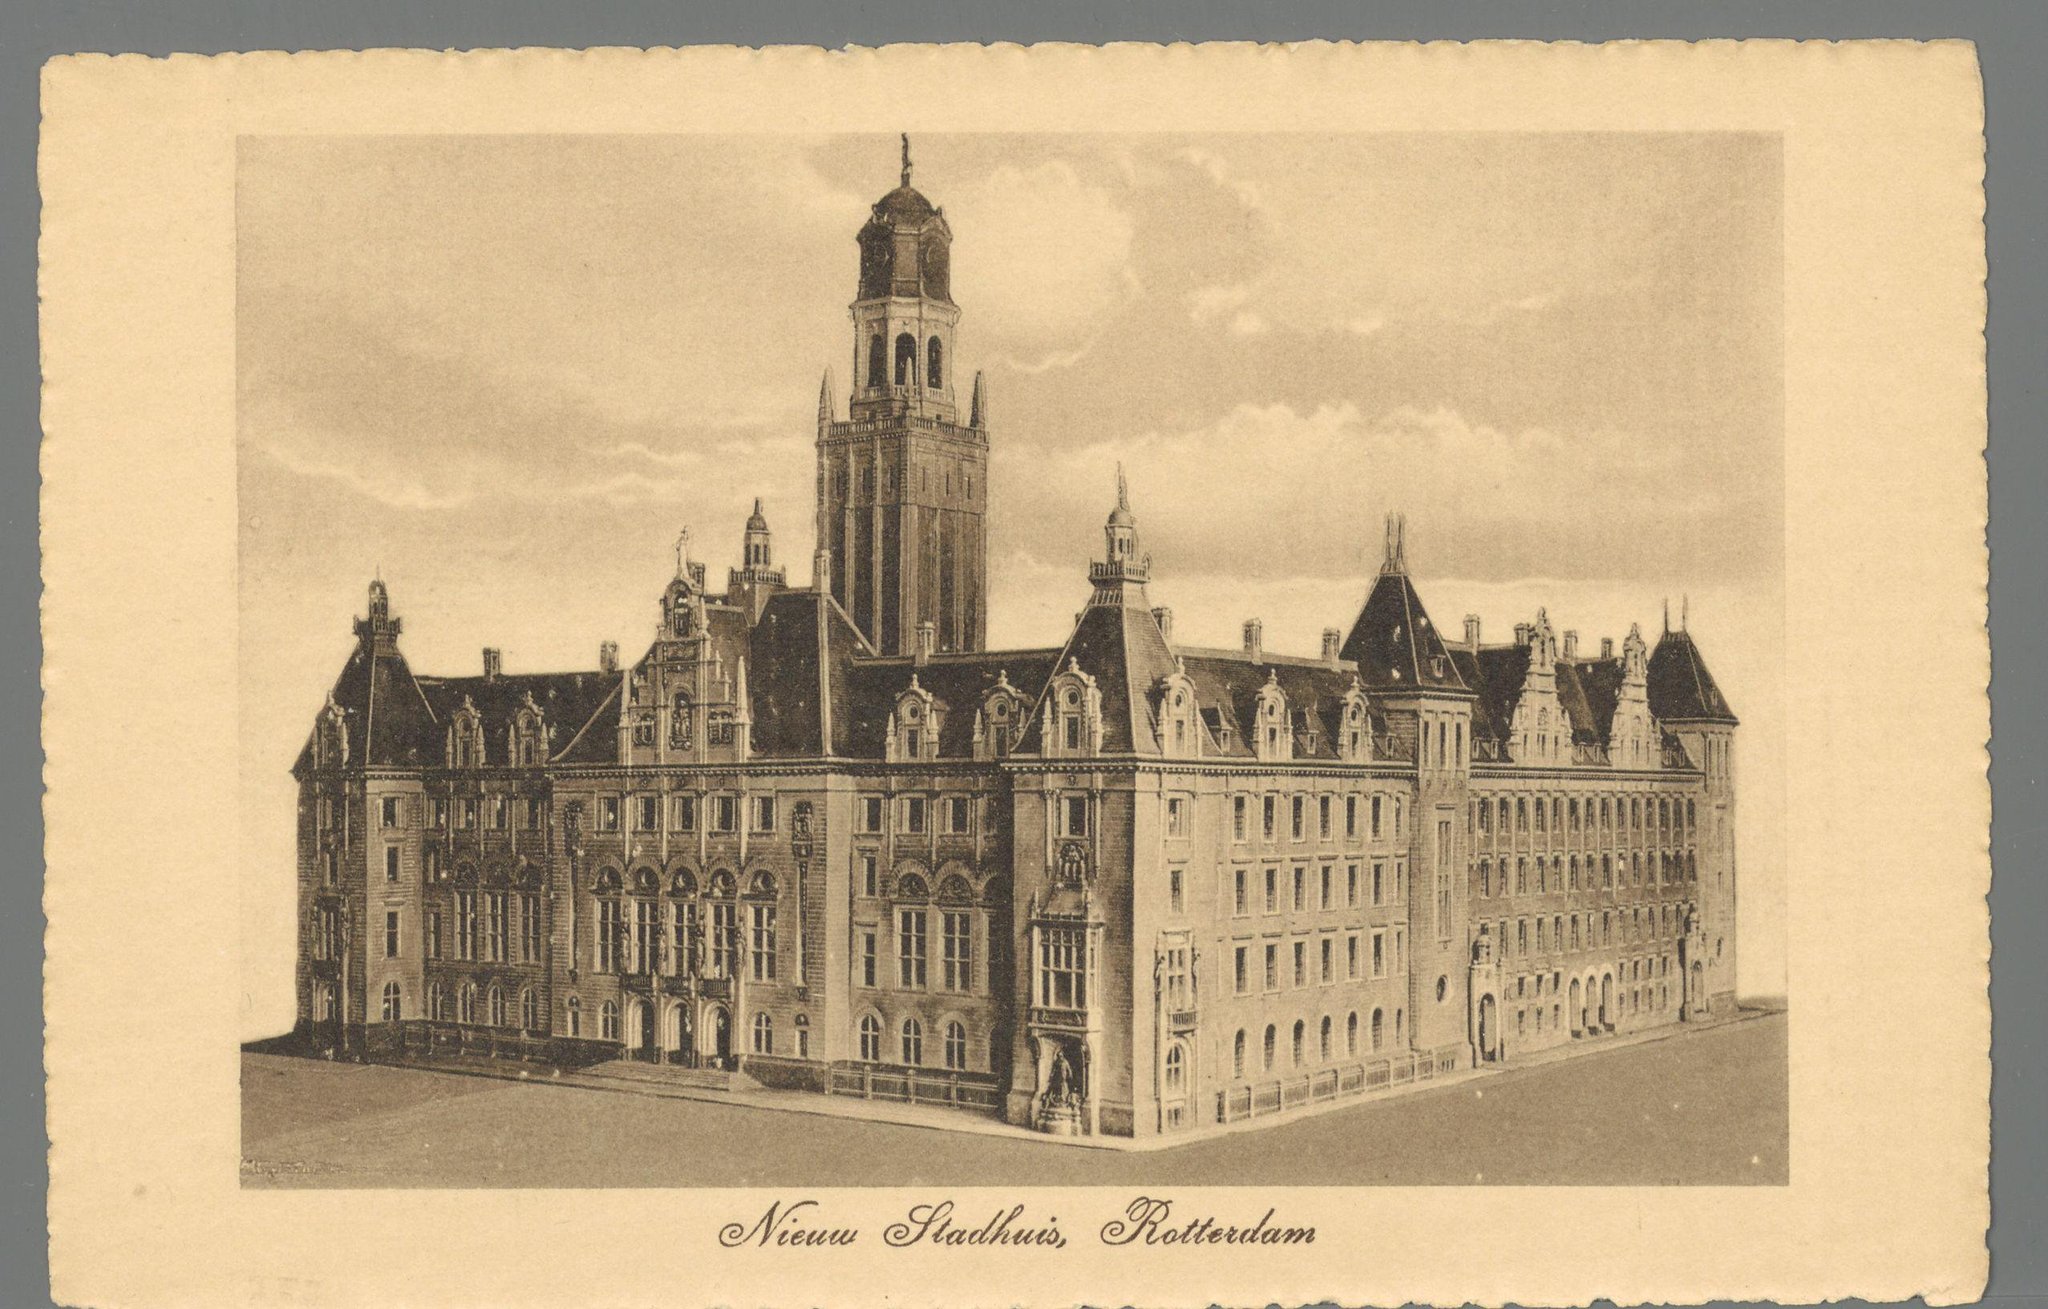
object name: photomechanical print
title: Nieuw Stadhuis, Rotterdam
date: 1913-1920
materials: cardboard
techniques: photograph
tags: model ~ architecture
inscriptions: stamp: ‘B.S.B.’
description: Maquette van het ontwerp voor het nieuwe stadhuis van Rotterdam van Henri Evers.